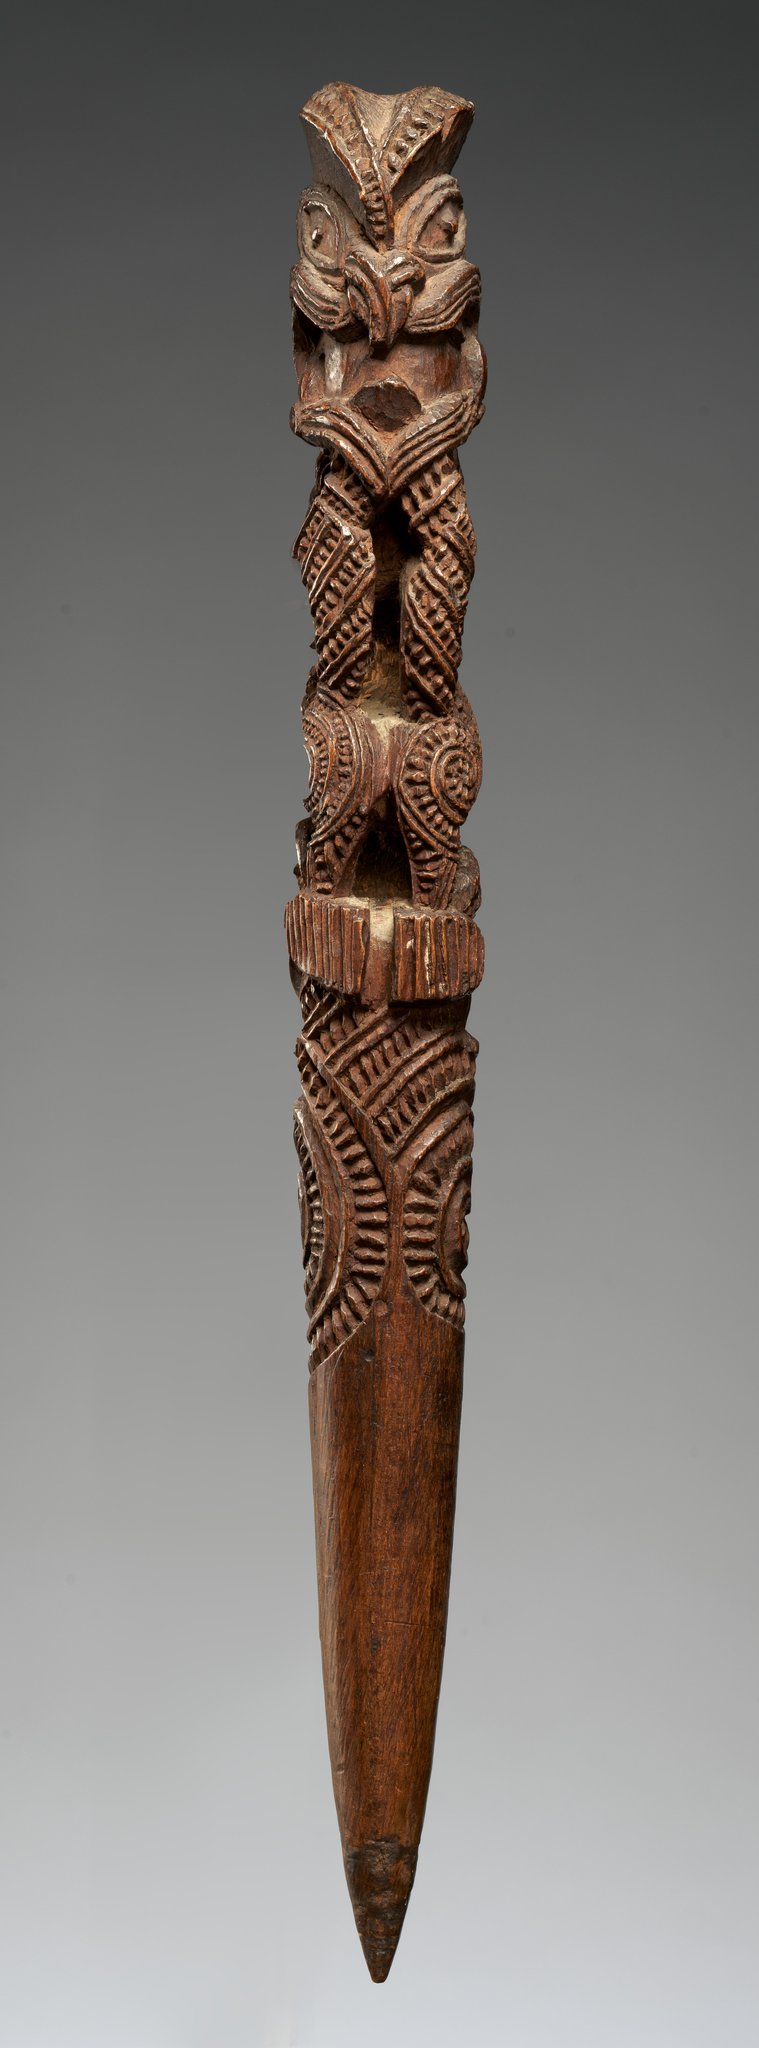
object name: weaving peg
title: Weaving Peg (Turuturu)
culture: maori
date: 1767-1833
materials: wood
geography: new zealand